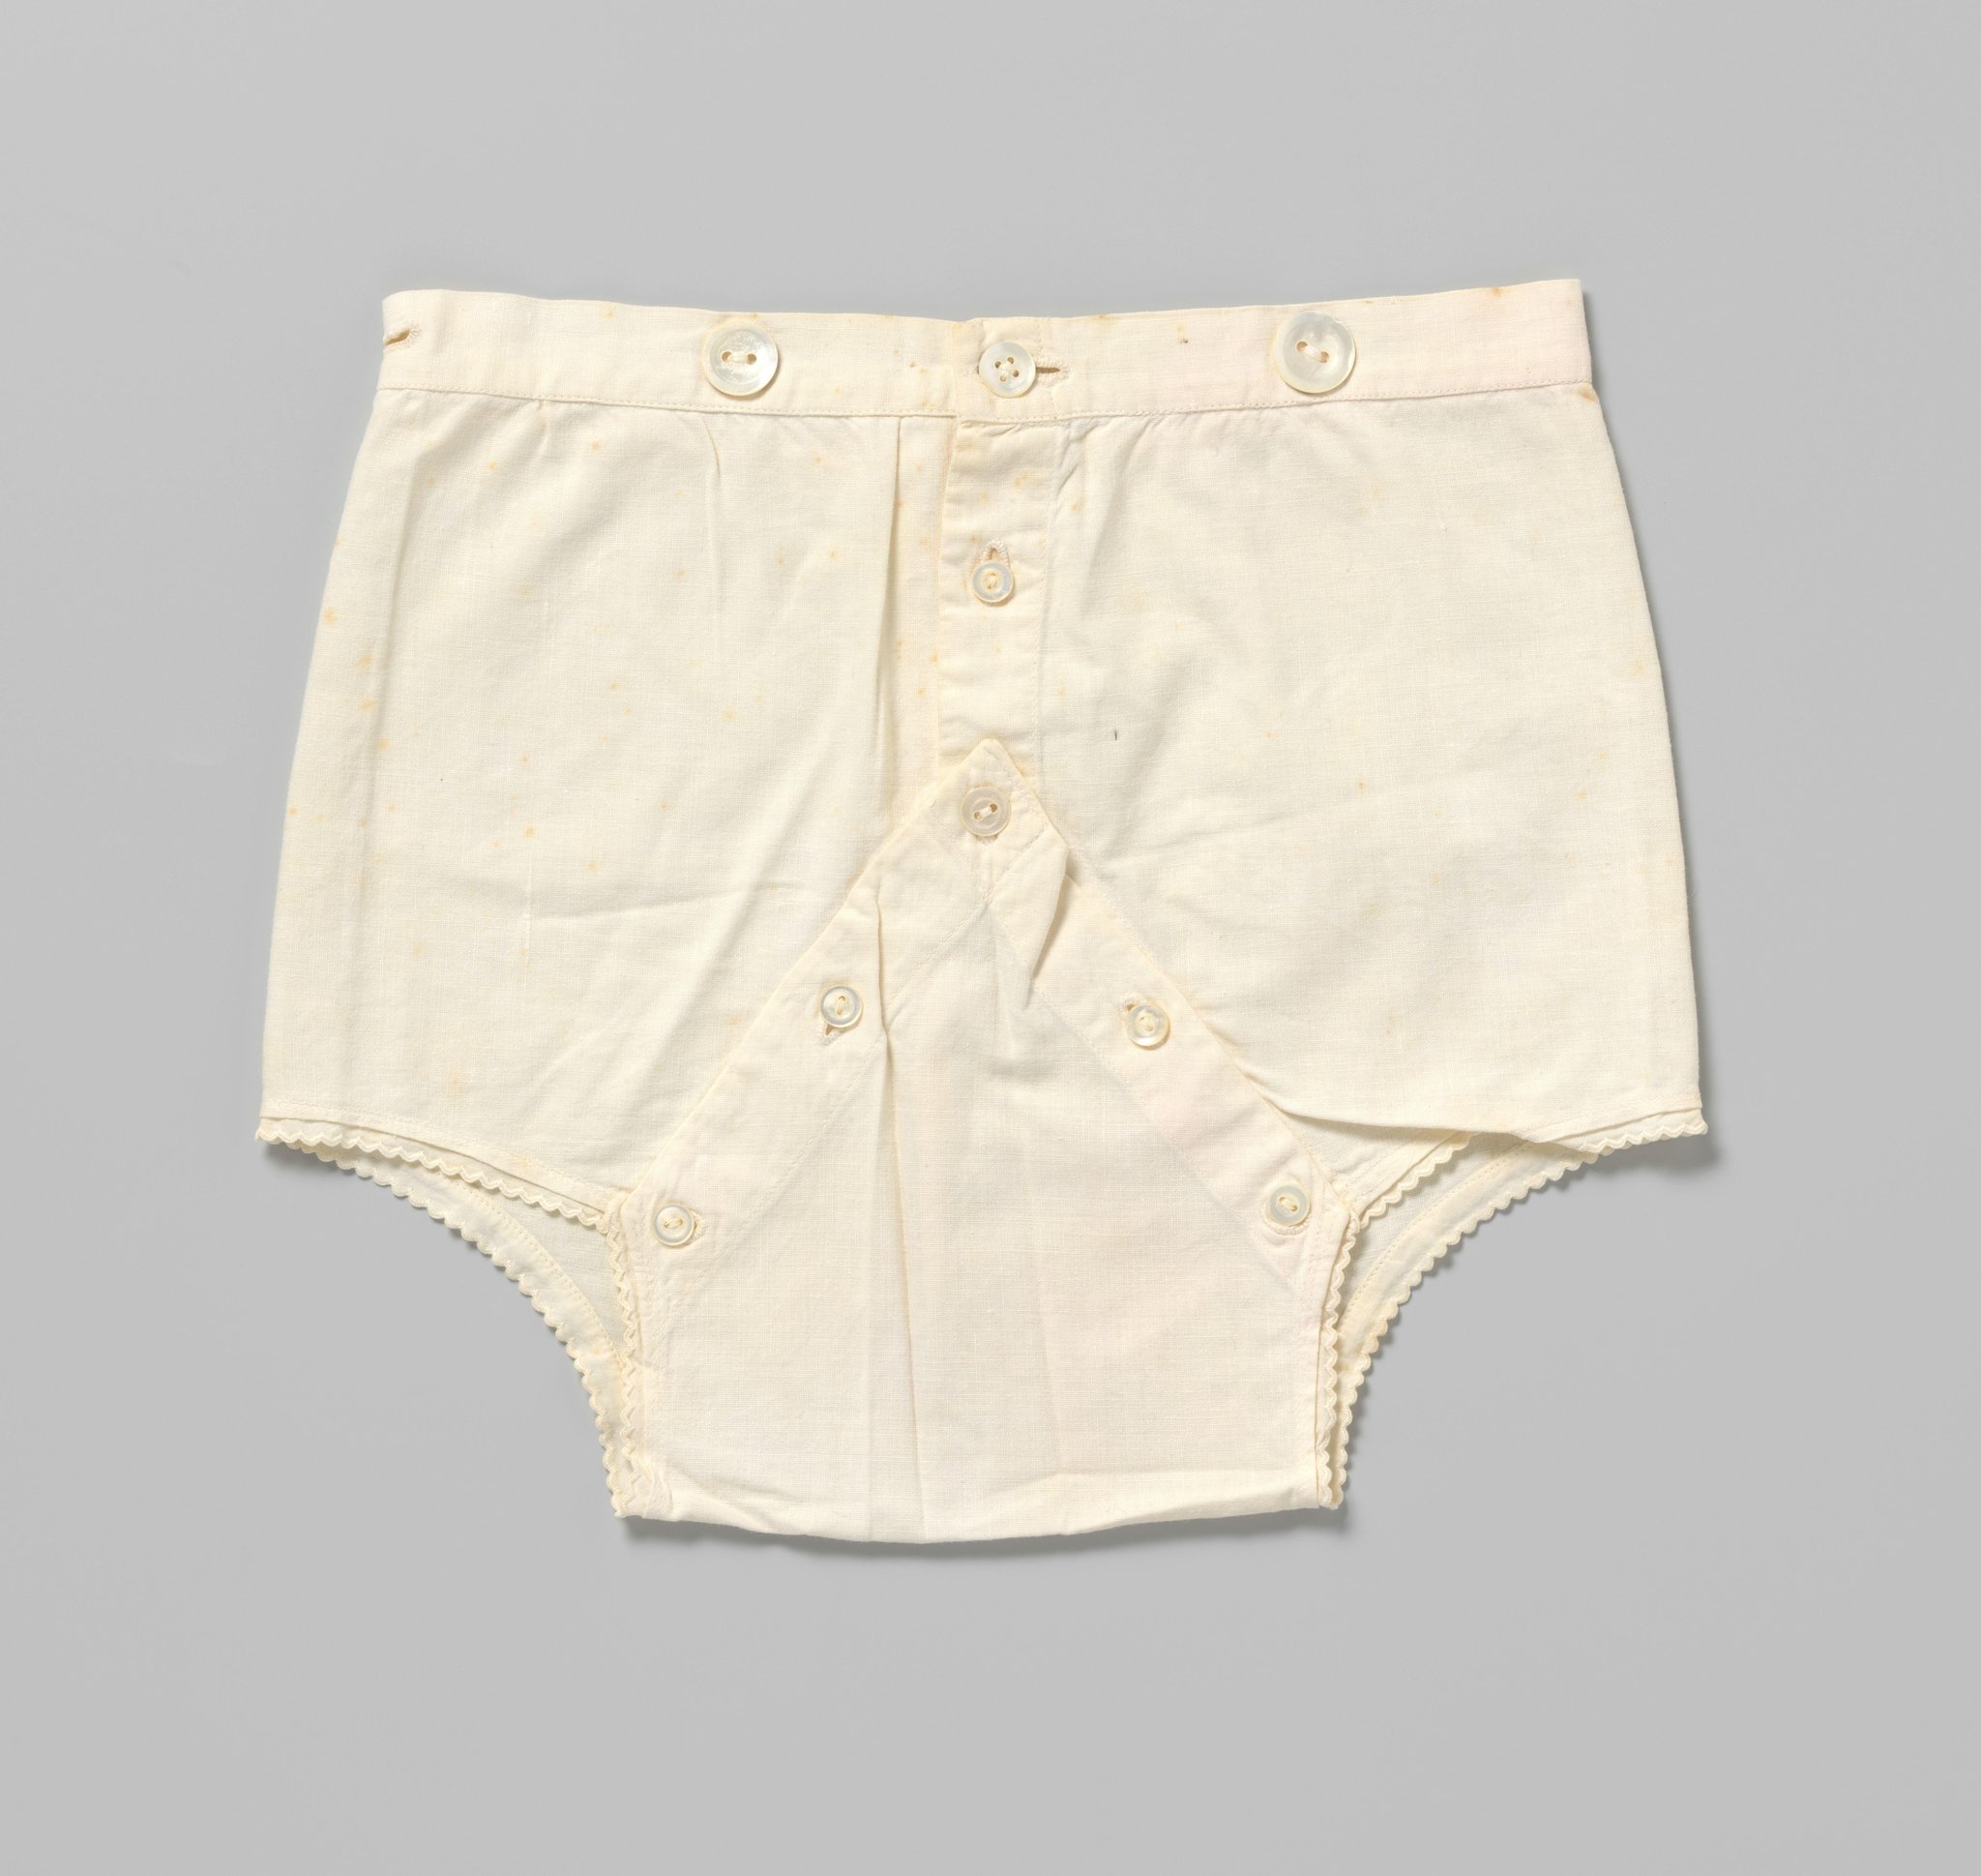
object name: pilch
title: Luierbroek van witte katoen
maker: m. insinger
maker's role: kleermaker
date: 1905-1910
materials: cotton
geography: tlogosari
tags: tlogosari, frederik karel insinger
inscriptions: signature and date: ‘gemerkt: 127 M.I.’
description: Luierbroek van witte katoen. Waarschijnlijk gedragen door Frederik Karel Insinger (geb. 30-8-1906).